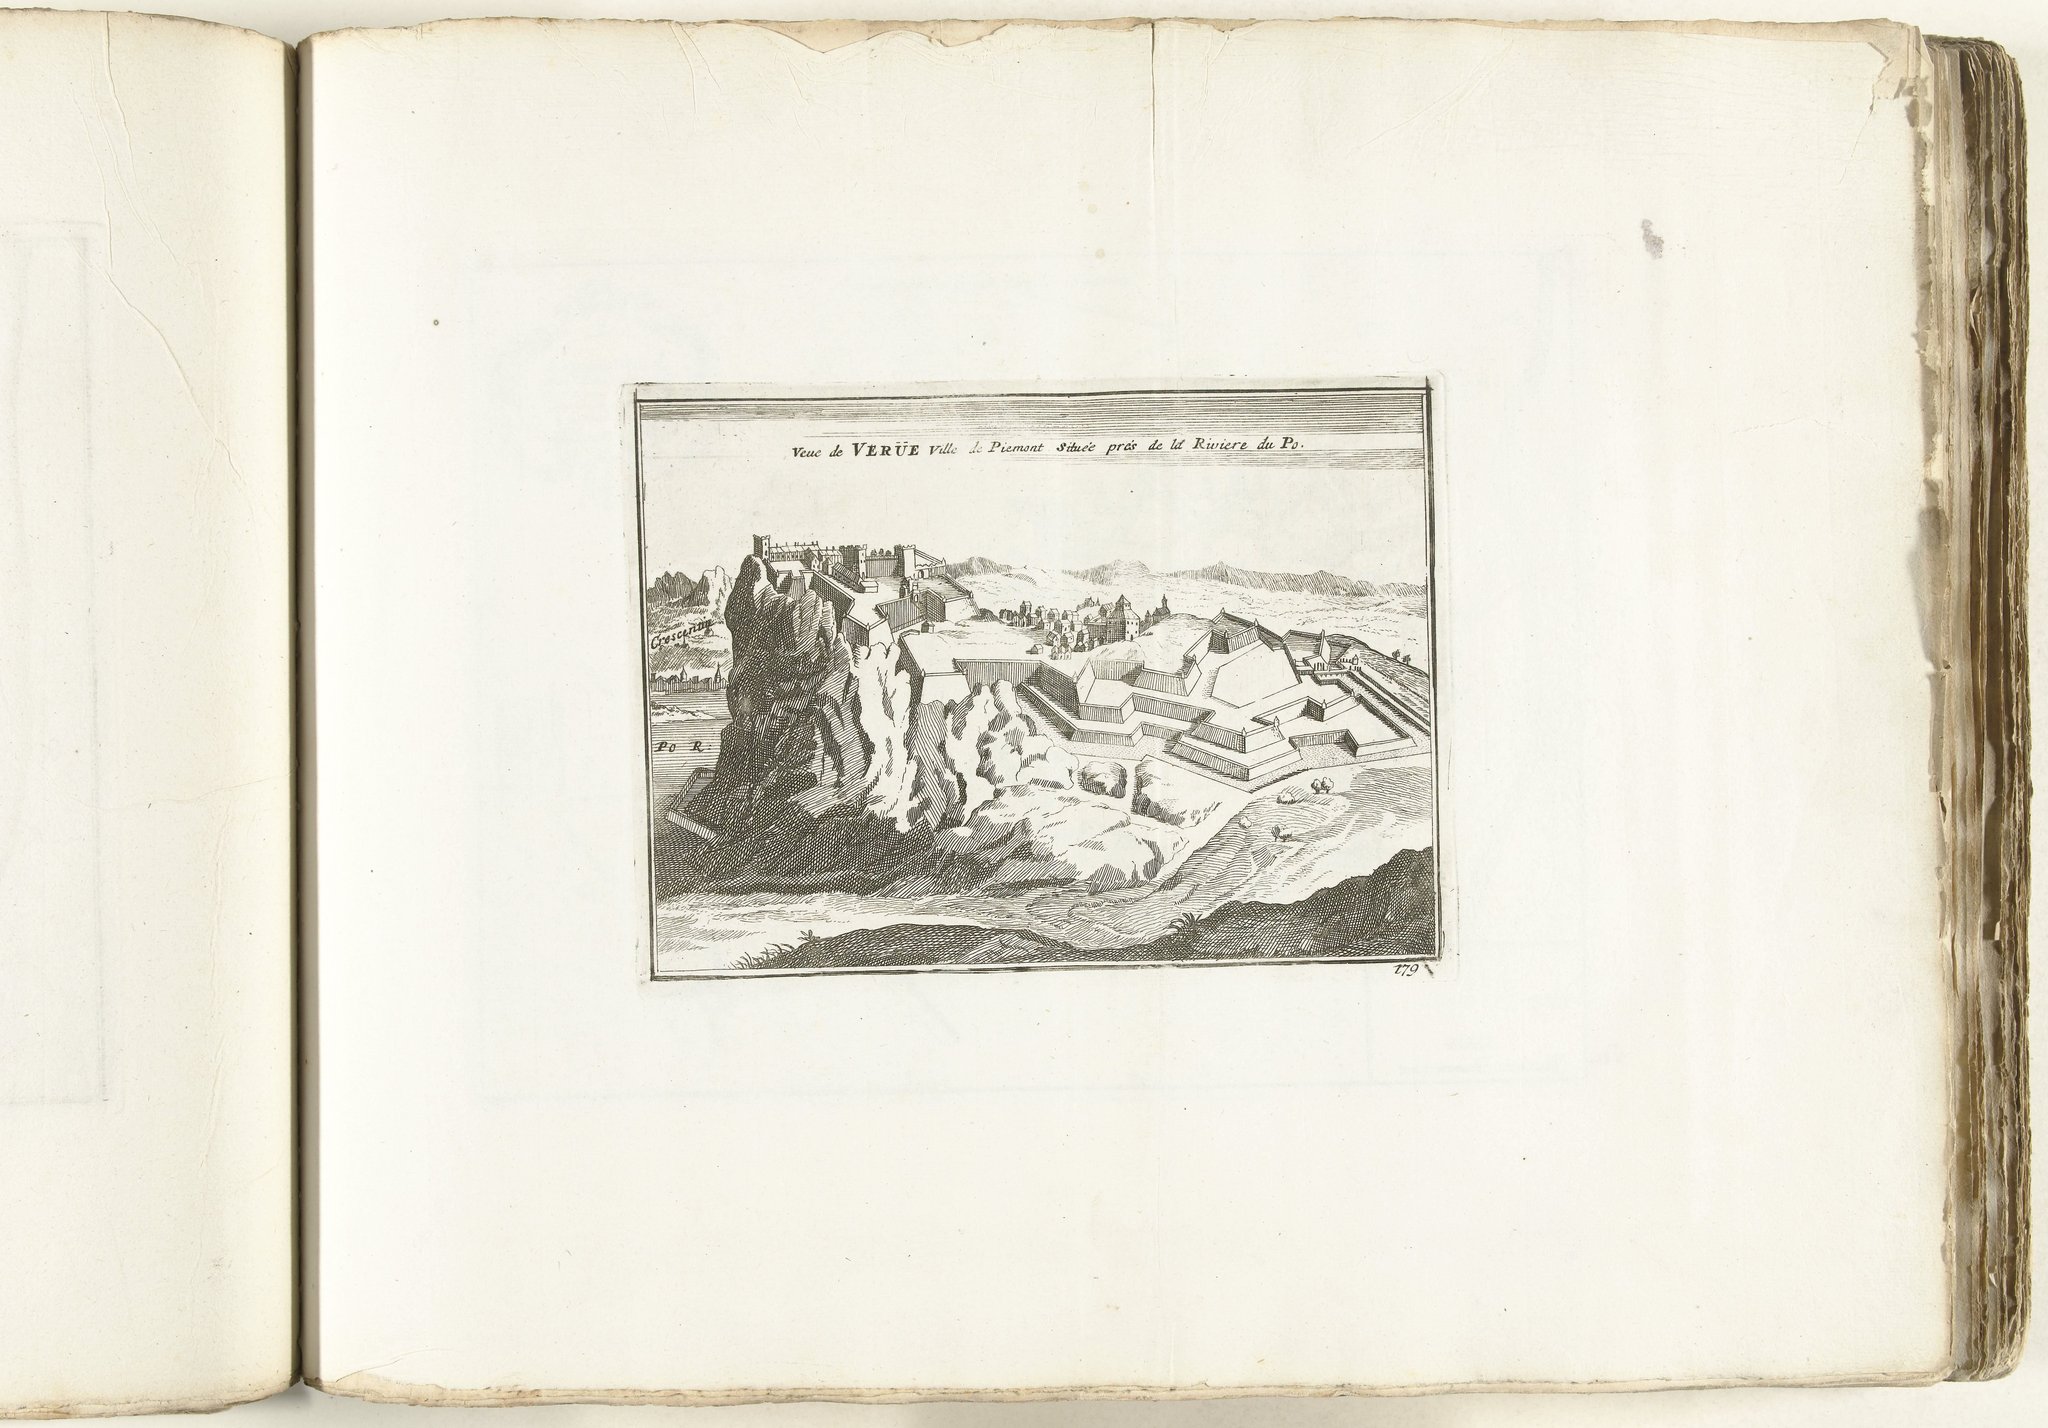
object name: print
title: Les Forces de l'Europe, Asie, Afrique et Amerique, ou description des principales villes avec leurs fortifications. Dessignées par les meilleurs ingenieurs, particulierement celles qui sont sous la domination de la France (...) et ornées de plusieurs superbes edifices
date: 1702-1703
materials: paper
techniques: etching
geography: amsterdam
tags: fortress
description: Gezicht op de stad Verua (Verue) aan de Po in Piemonte. Plaat nr. 179 in het prentwerk bestaande in totaal uit 276 genummerde platen van vermaarde sterke steden en vestingen in het kader van de Spaanse Successieoorlog. Voor het merendeel zijn deze platen gekopieerd naar de anonieme Franse platen: in Les forces de l'Europe en in: Le theatre de la guerre, dans les Pays-Bas, beide oorspronkelijk uitgegeven door Nicolas de Fer te Parijs (1693-1697) in het kader van de Negenjarige Oorlog. Titel en opschriften in de plaat in het Frans.